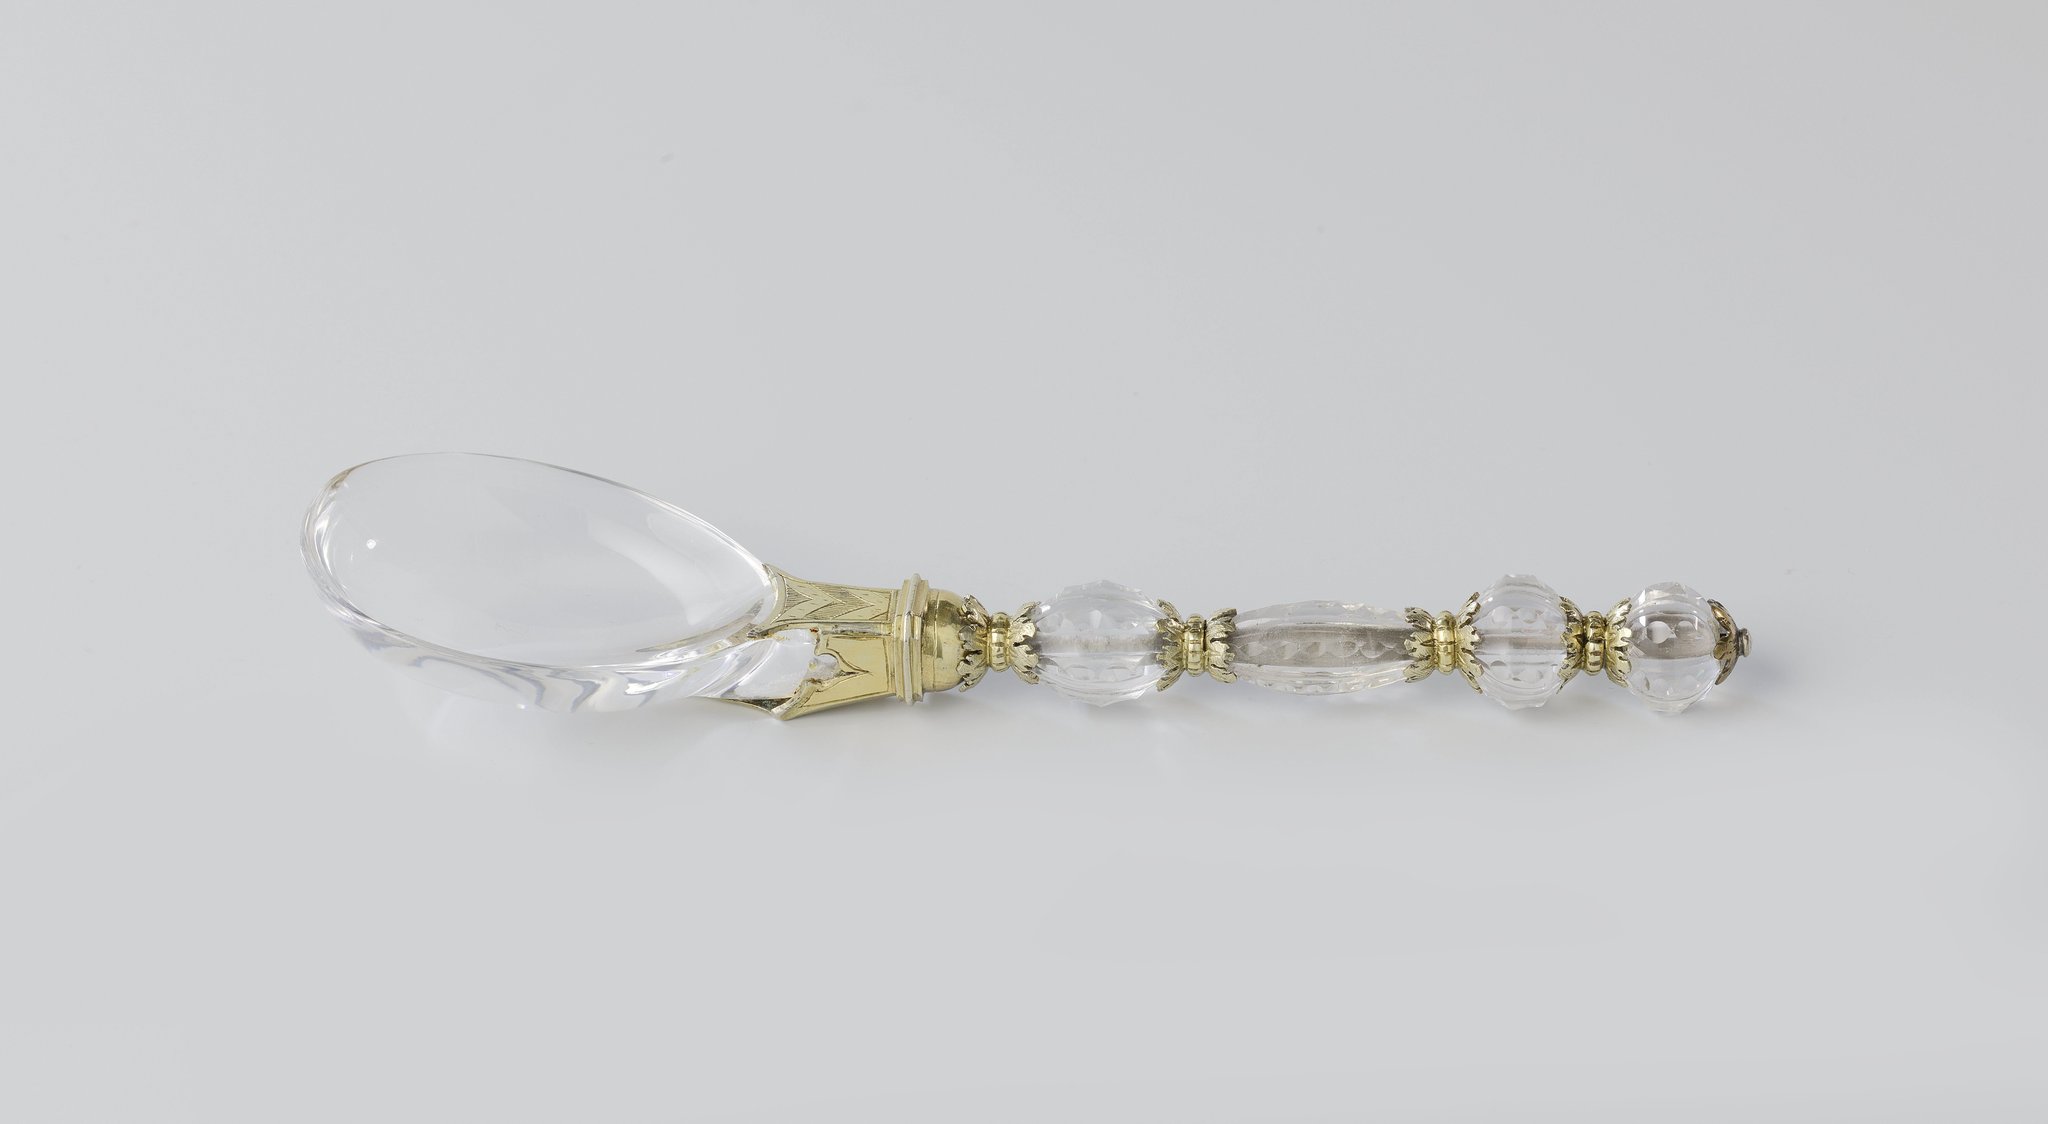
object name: table knife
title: Mes van geslepen bergkristal met verguld zilver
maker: Anonymous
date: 1600-1650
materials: silver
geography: freiburg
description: Goblet. Rock crystal, gold and enamel. Germany, c. 1600-1625. Knife, fork and spoon. Rock crystal and silver-gilt. Breisgau, c. 1600-1650.